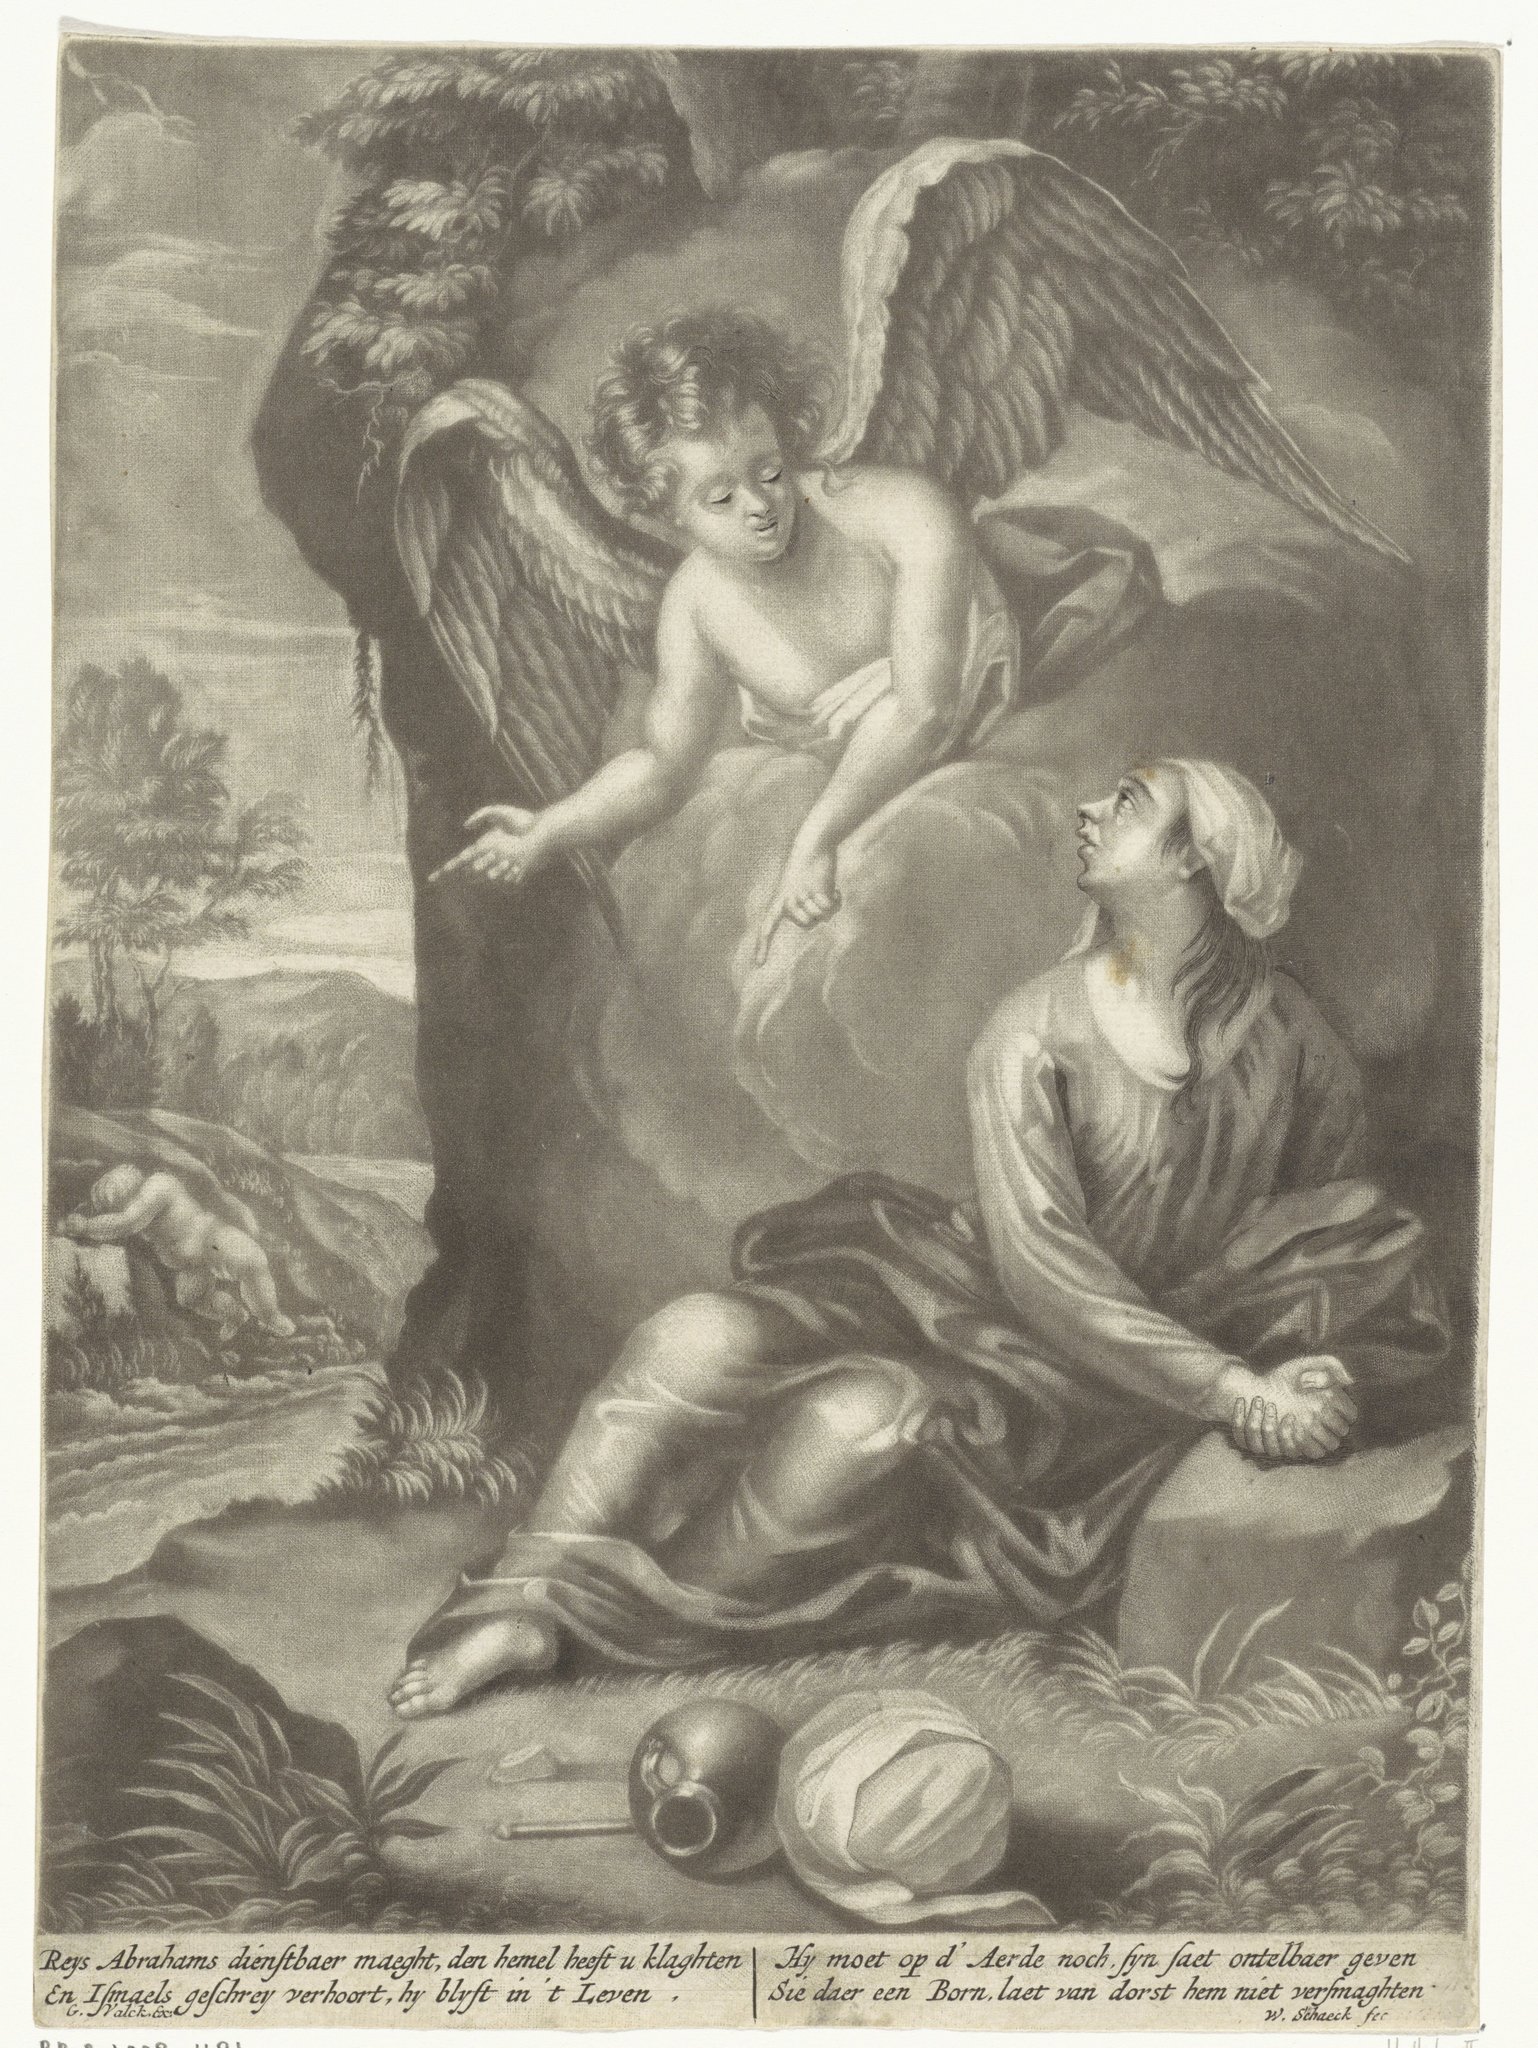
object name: print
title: Hagar en Ismaël in de wildernis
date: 1680-1726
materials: paper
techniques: mezzotint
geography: amsterdam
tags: an angel appears and reveals a well of water to hagar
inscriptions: collector's mark: Lugt 2228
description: Een engel wijst Hagar de weg naar een bron. Op de achtergrond ligt haar zoon Ismaël op de grond.